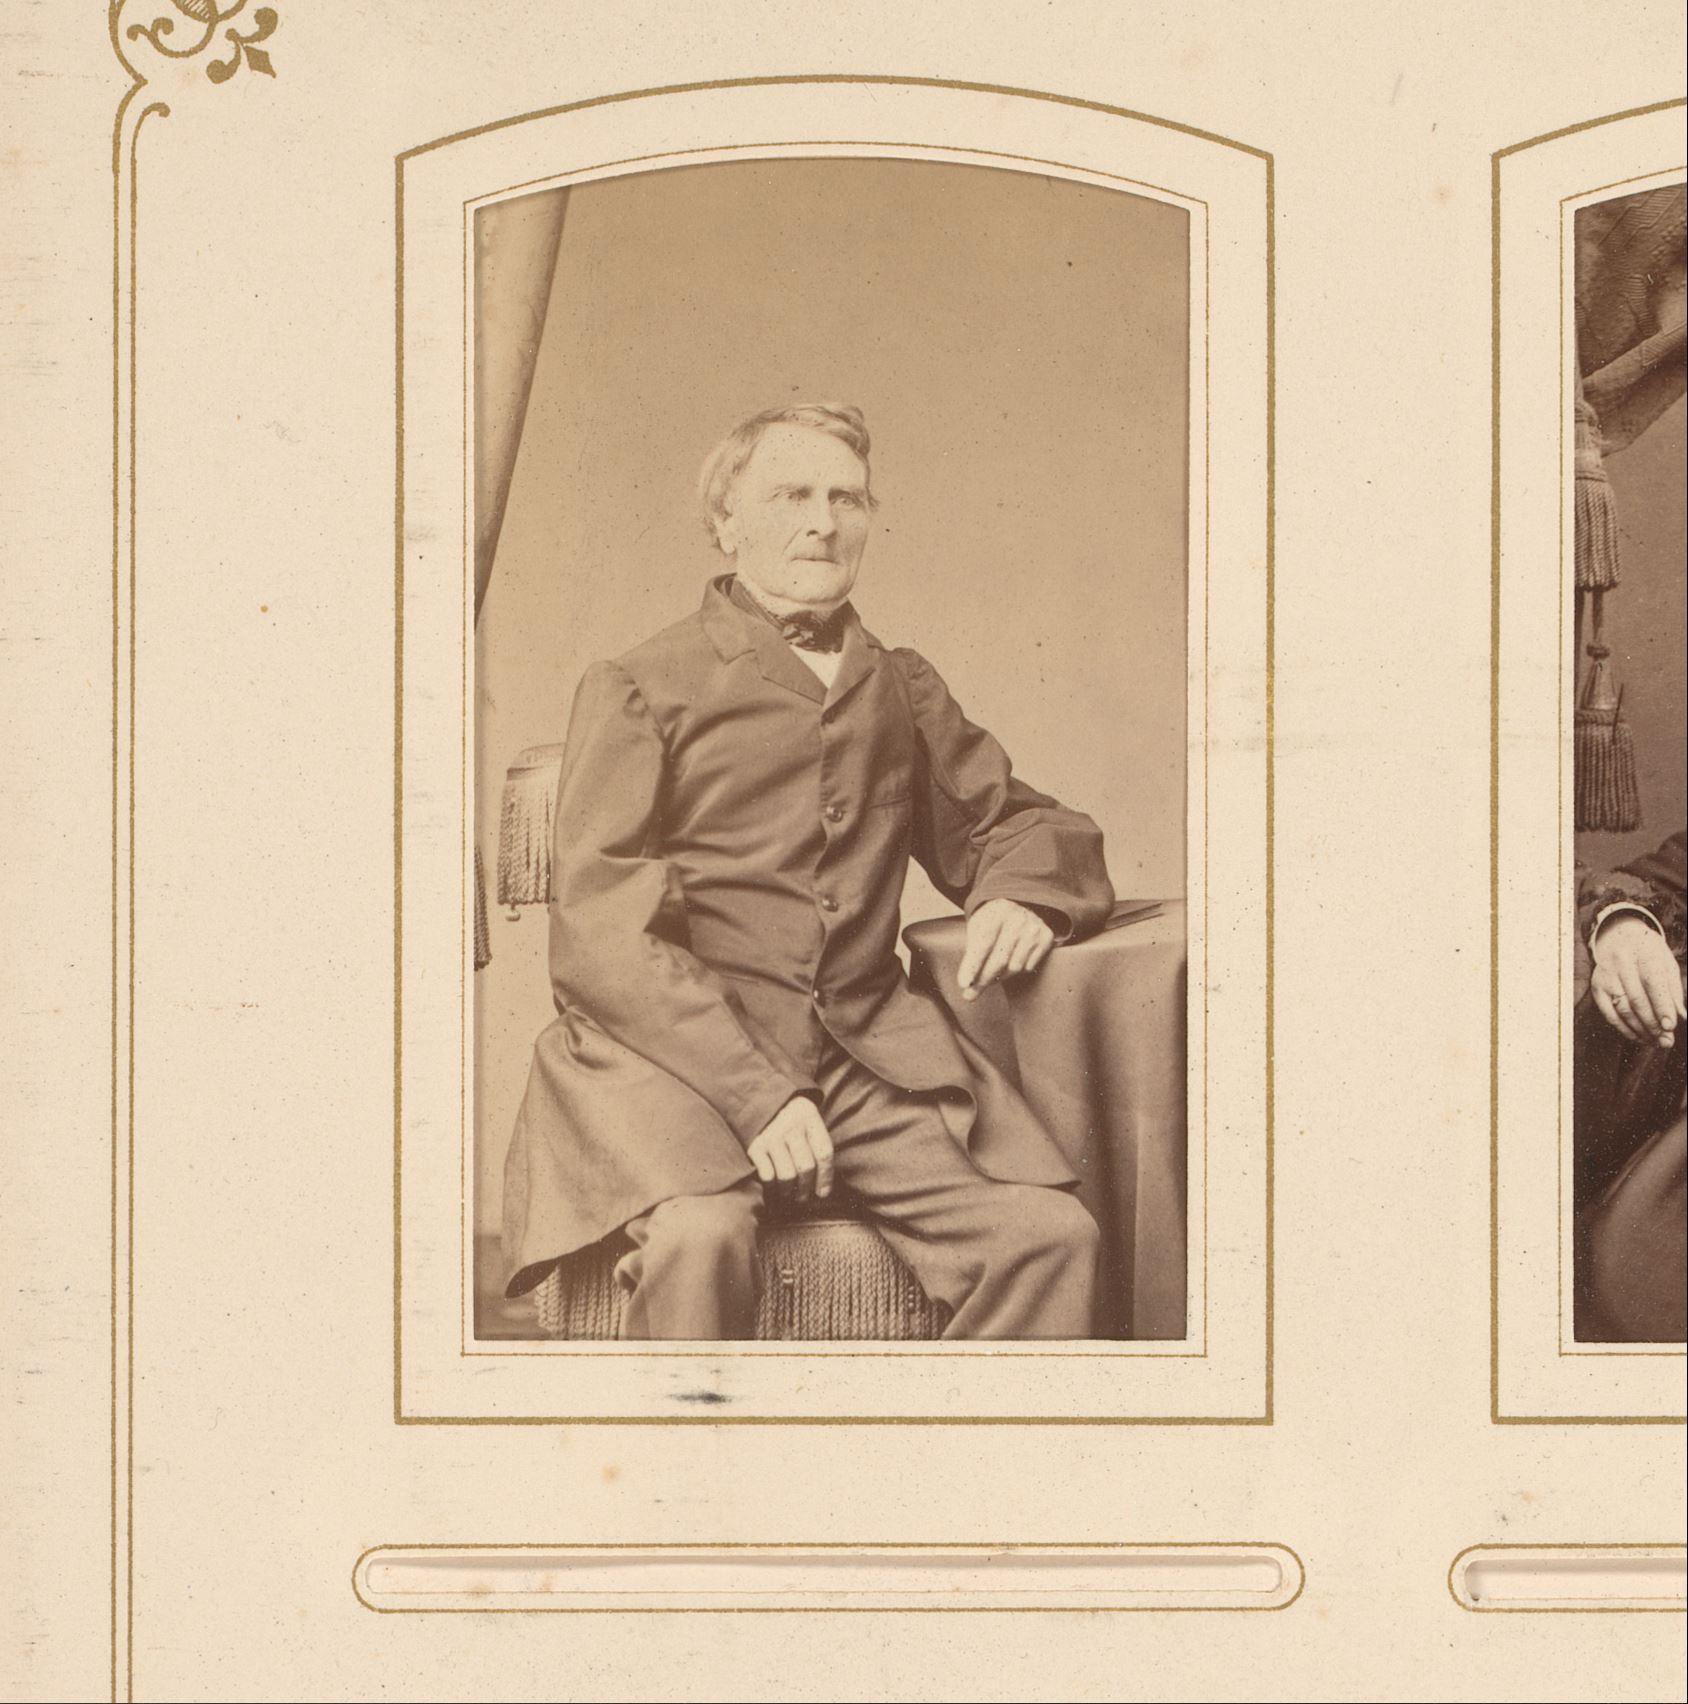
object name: carte de visite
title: Portret van een man aan tafel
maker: a. bussenius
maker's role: fotograaf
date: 1850-1900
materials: cardboard, photographic support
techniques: albumen print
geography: stade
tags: historical persons, chair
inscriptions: inscription: ‘Photographisches/ JNSTITUT/ von/ Dr. A. Bussenius/ STADE/ Ecke der/ Höcker- & Kleinschmiede-/ STRASSE/ 239.’